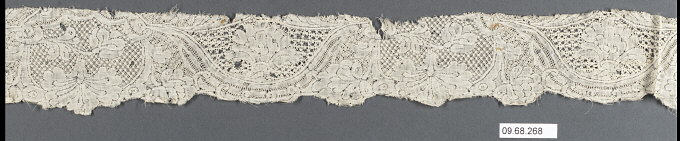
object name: border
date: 1701-1733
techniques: lace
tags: flowers